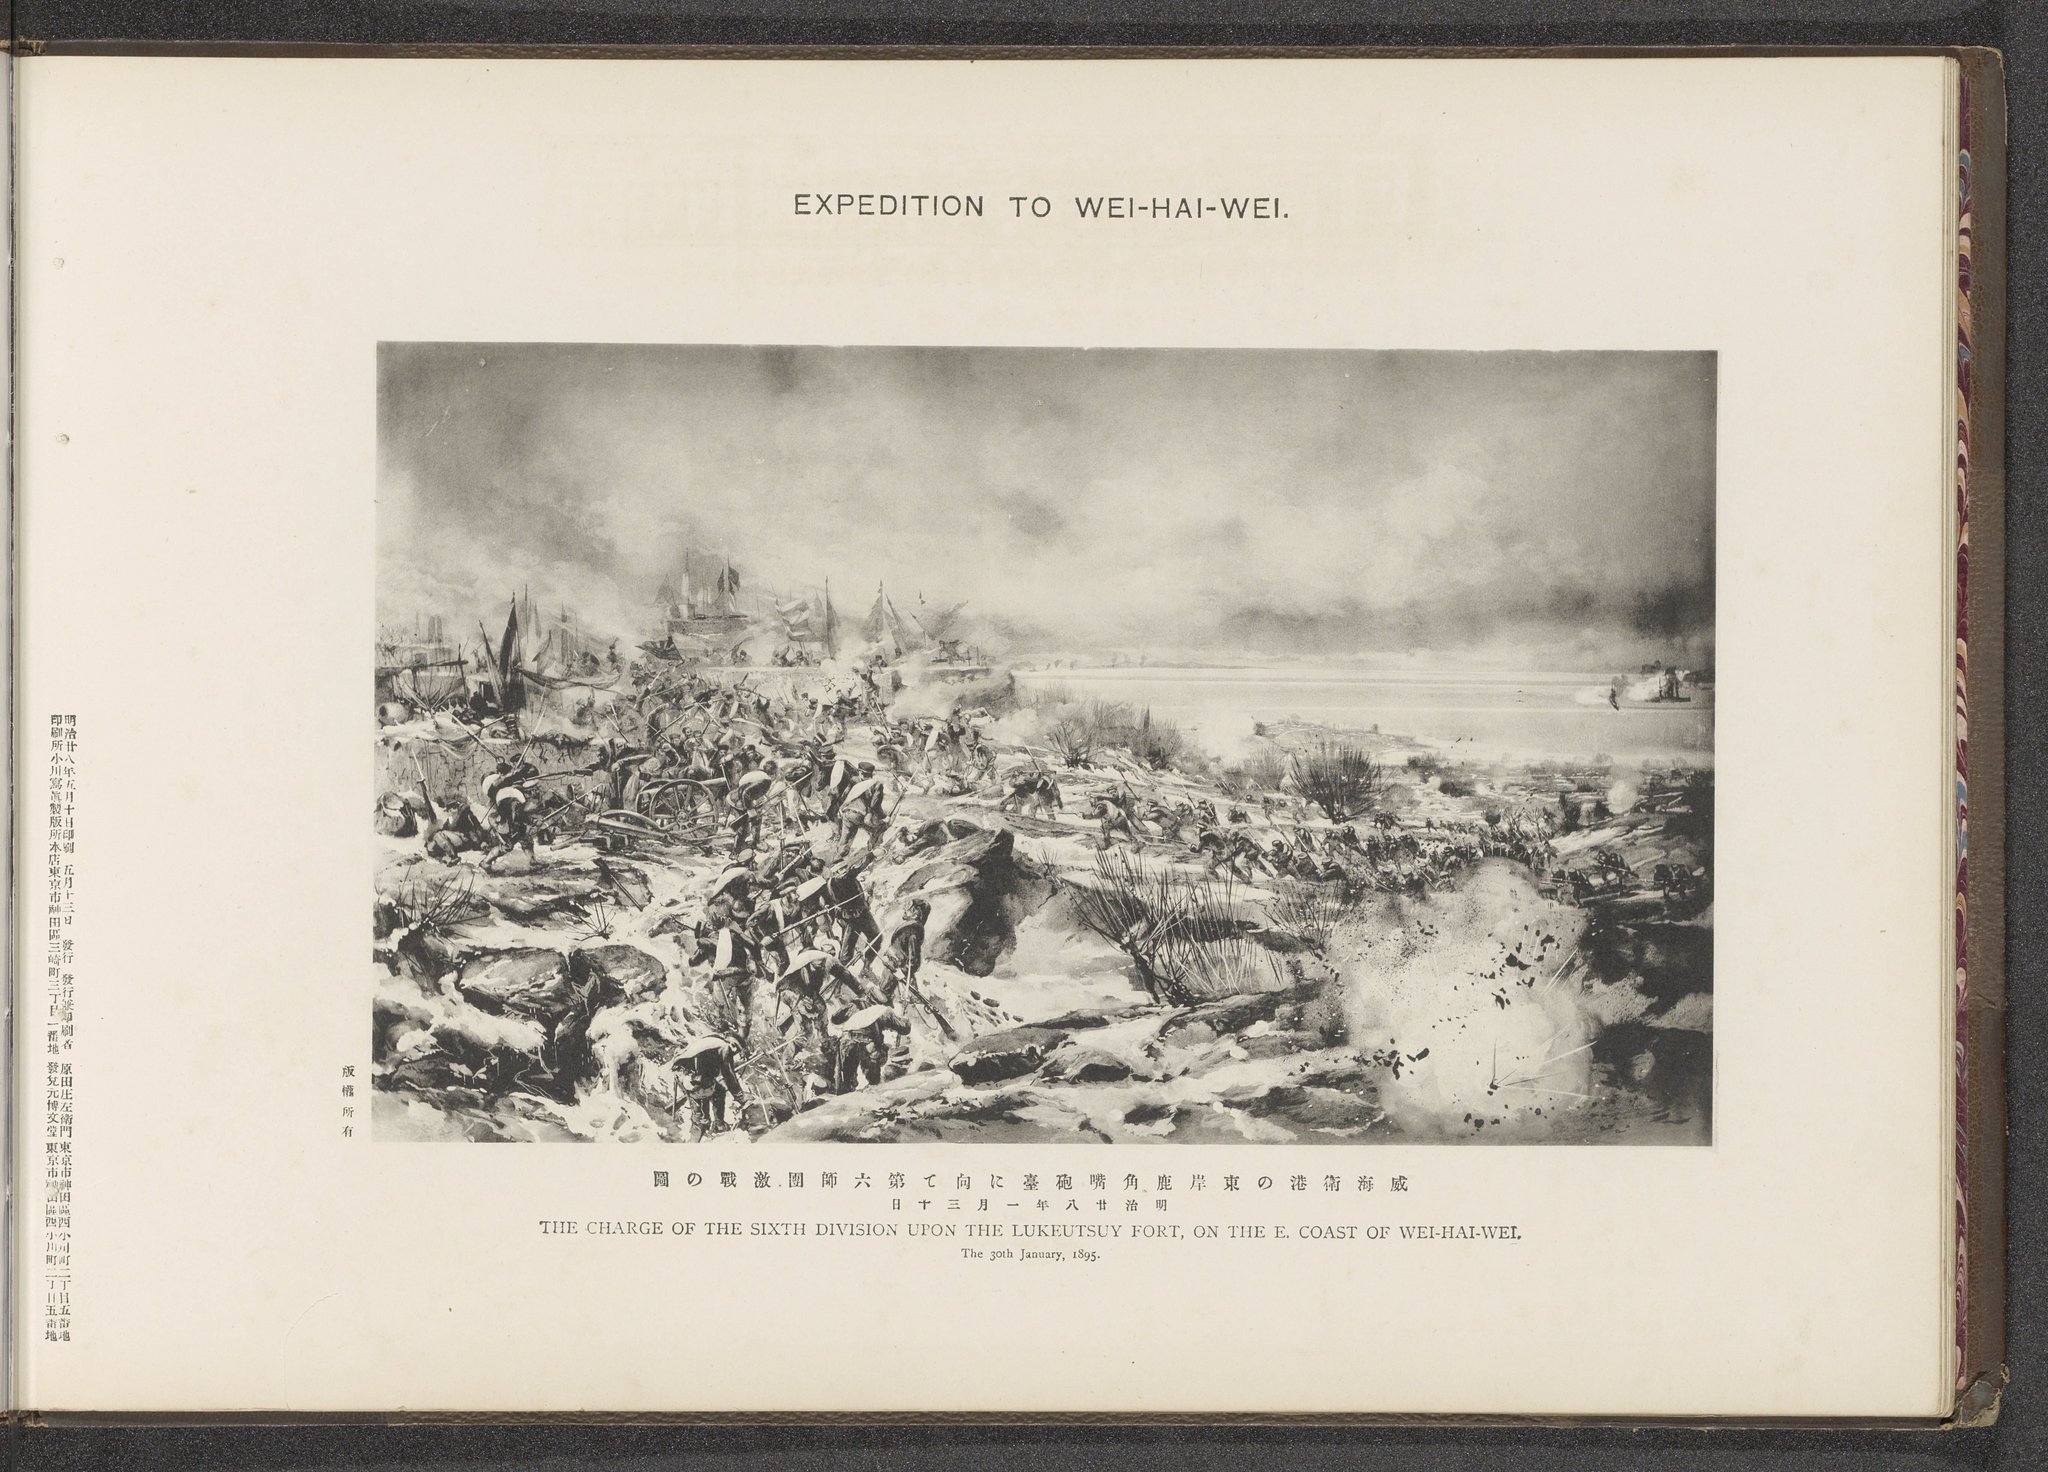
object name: photomechanical print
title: The charge of the sixth division upon the Lukeutsuy fort, on the E. coast of Wei-Hai-Wei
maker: kazumasa ogawa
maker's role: auteur, fotograaf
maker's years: 1860-1929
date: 1894-1895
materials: paper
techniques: photograph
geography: japan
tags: fortress, land forces, charge ~ battle